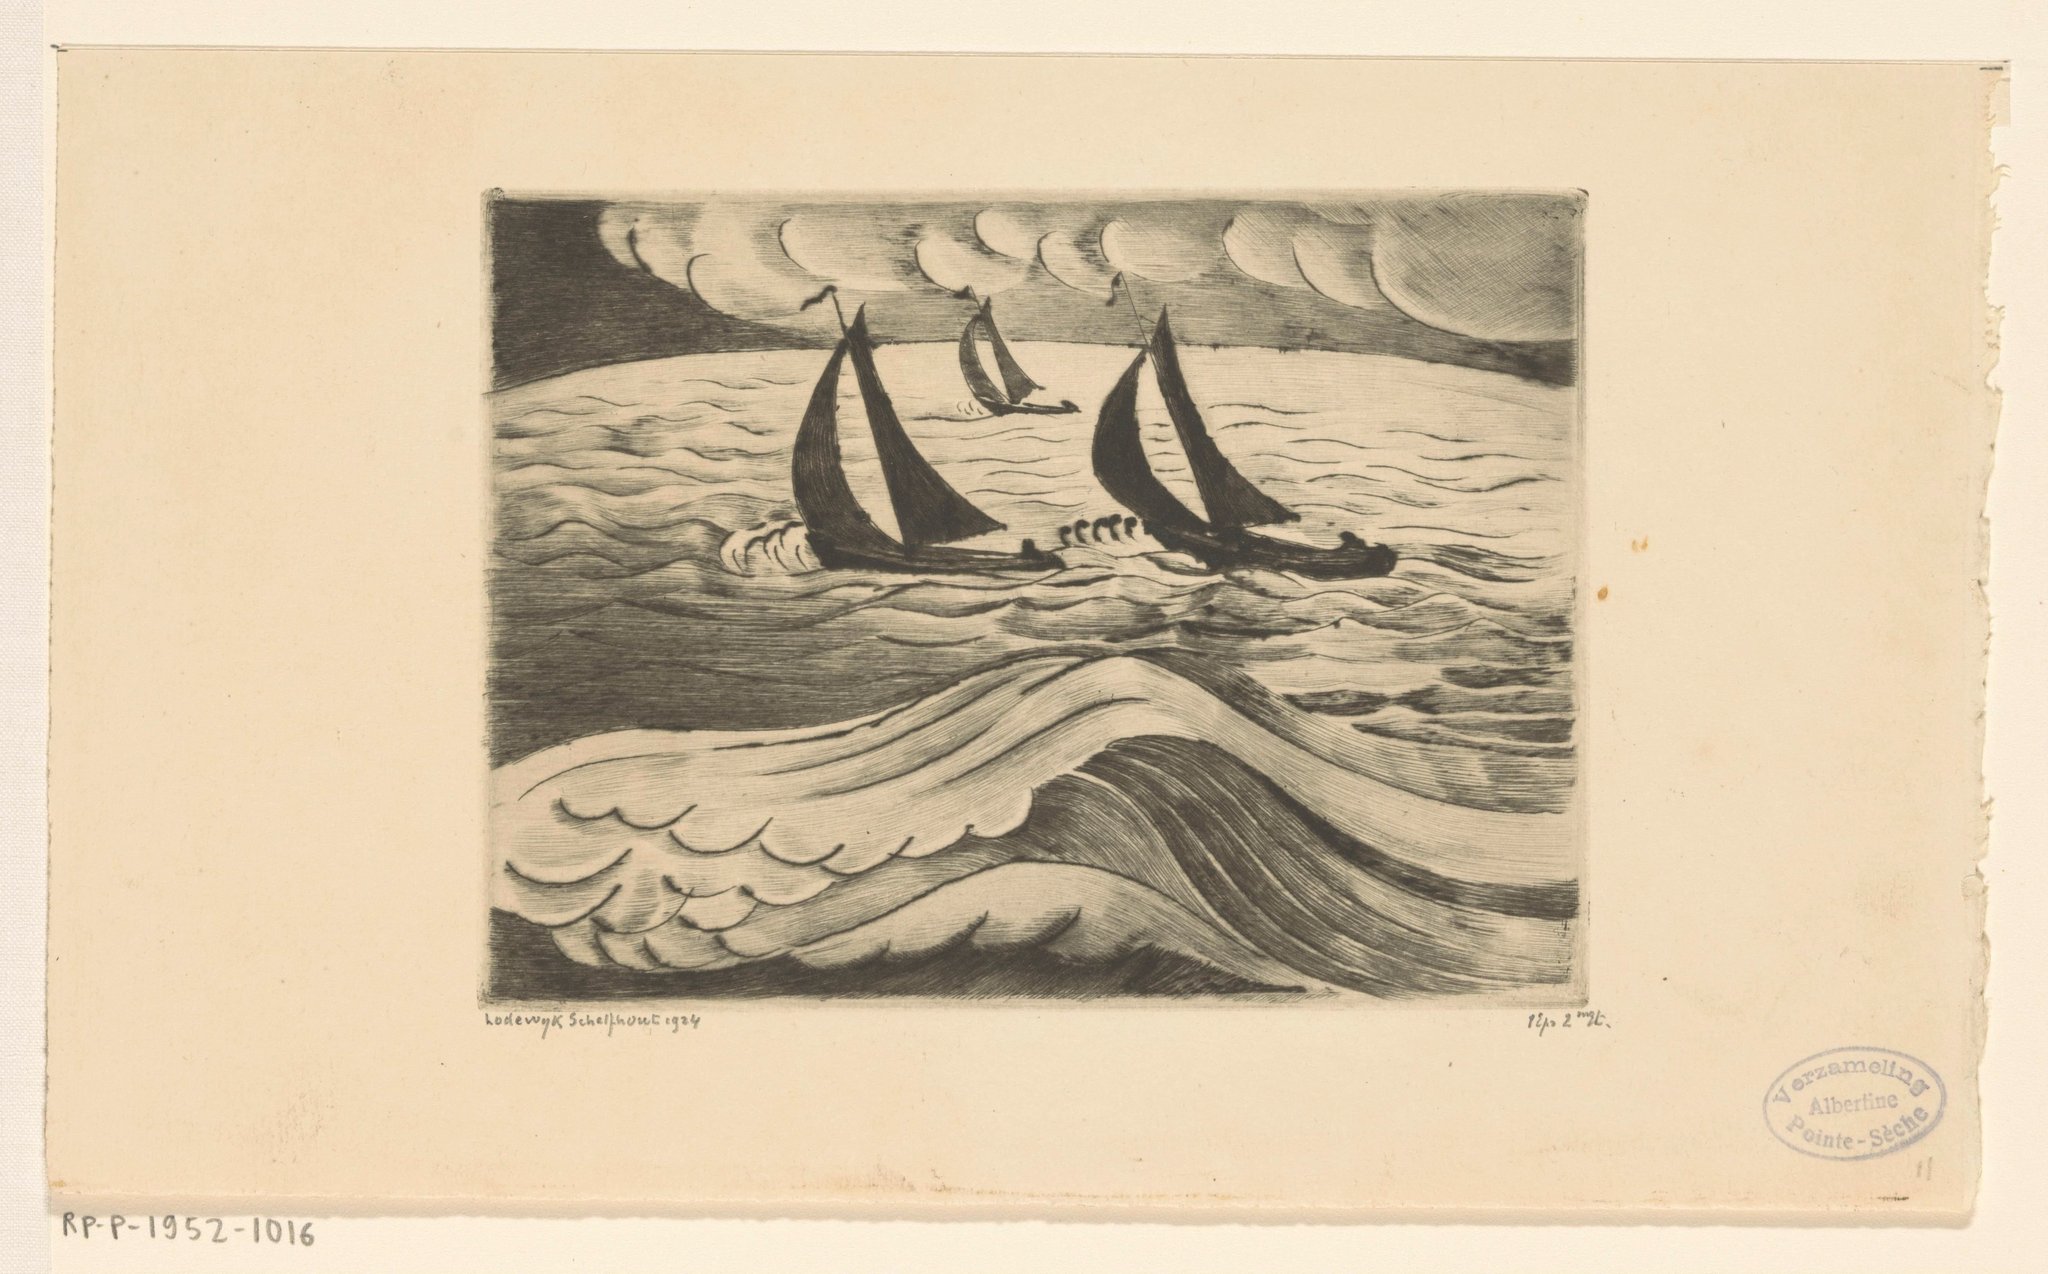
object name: print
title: Drie zeilschepen bij storm op zee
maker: lodewijk schelfhout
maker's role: draughtsman, print maker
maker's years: 1881-1943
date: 1924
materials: paper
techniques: drypoint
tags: sailing-ship, sailing-boat, storm at sea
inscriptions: collector's mark: Lugt 2228, collector's mark: Lugt 5i, collector's mark: Lugt 2760